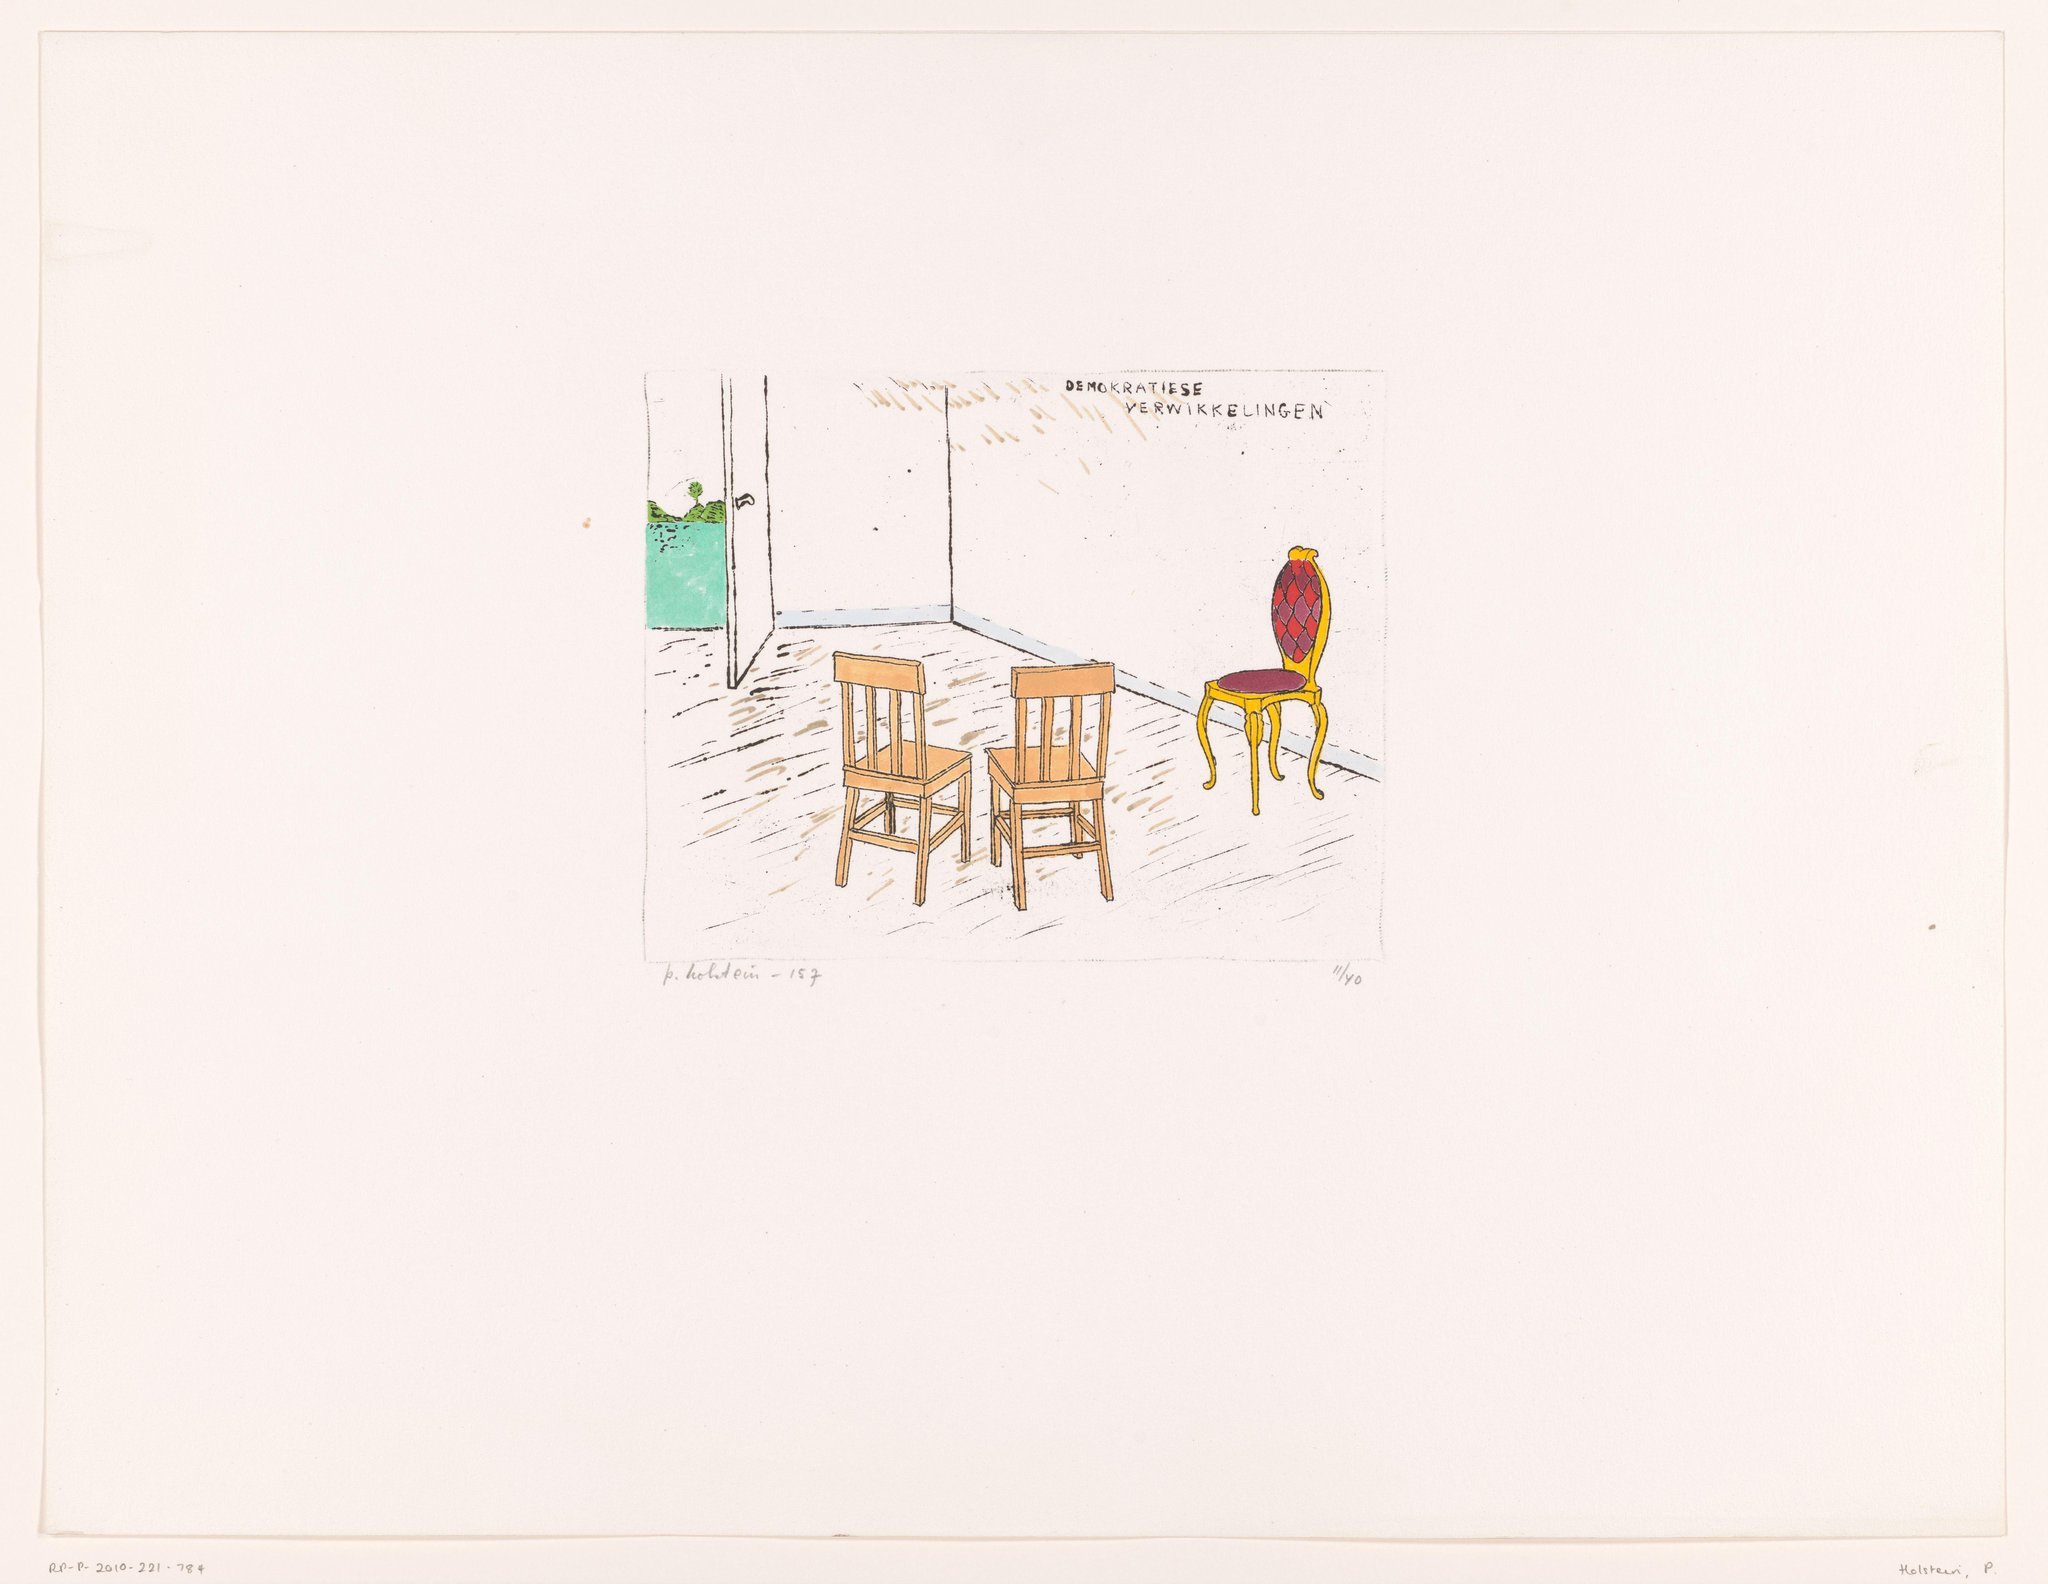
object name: print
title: Democratische verwikkelingen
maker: pieter holstein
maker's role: draughtsman, painter, print maker, sculptor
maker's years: 1934-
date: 1970-1980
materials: paper, watercolor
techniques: brush, etching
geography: amsterdam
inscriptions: signature: ‘p. holstein’, title: ‘DEMOKRATIESE VERWIKKELINGEN’, edition: ‘11/40’, inscription: ‘157’